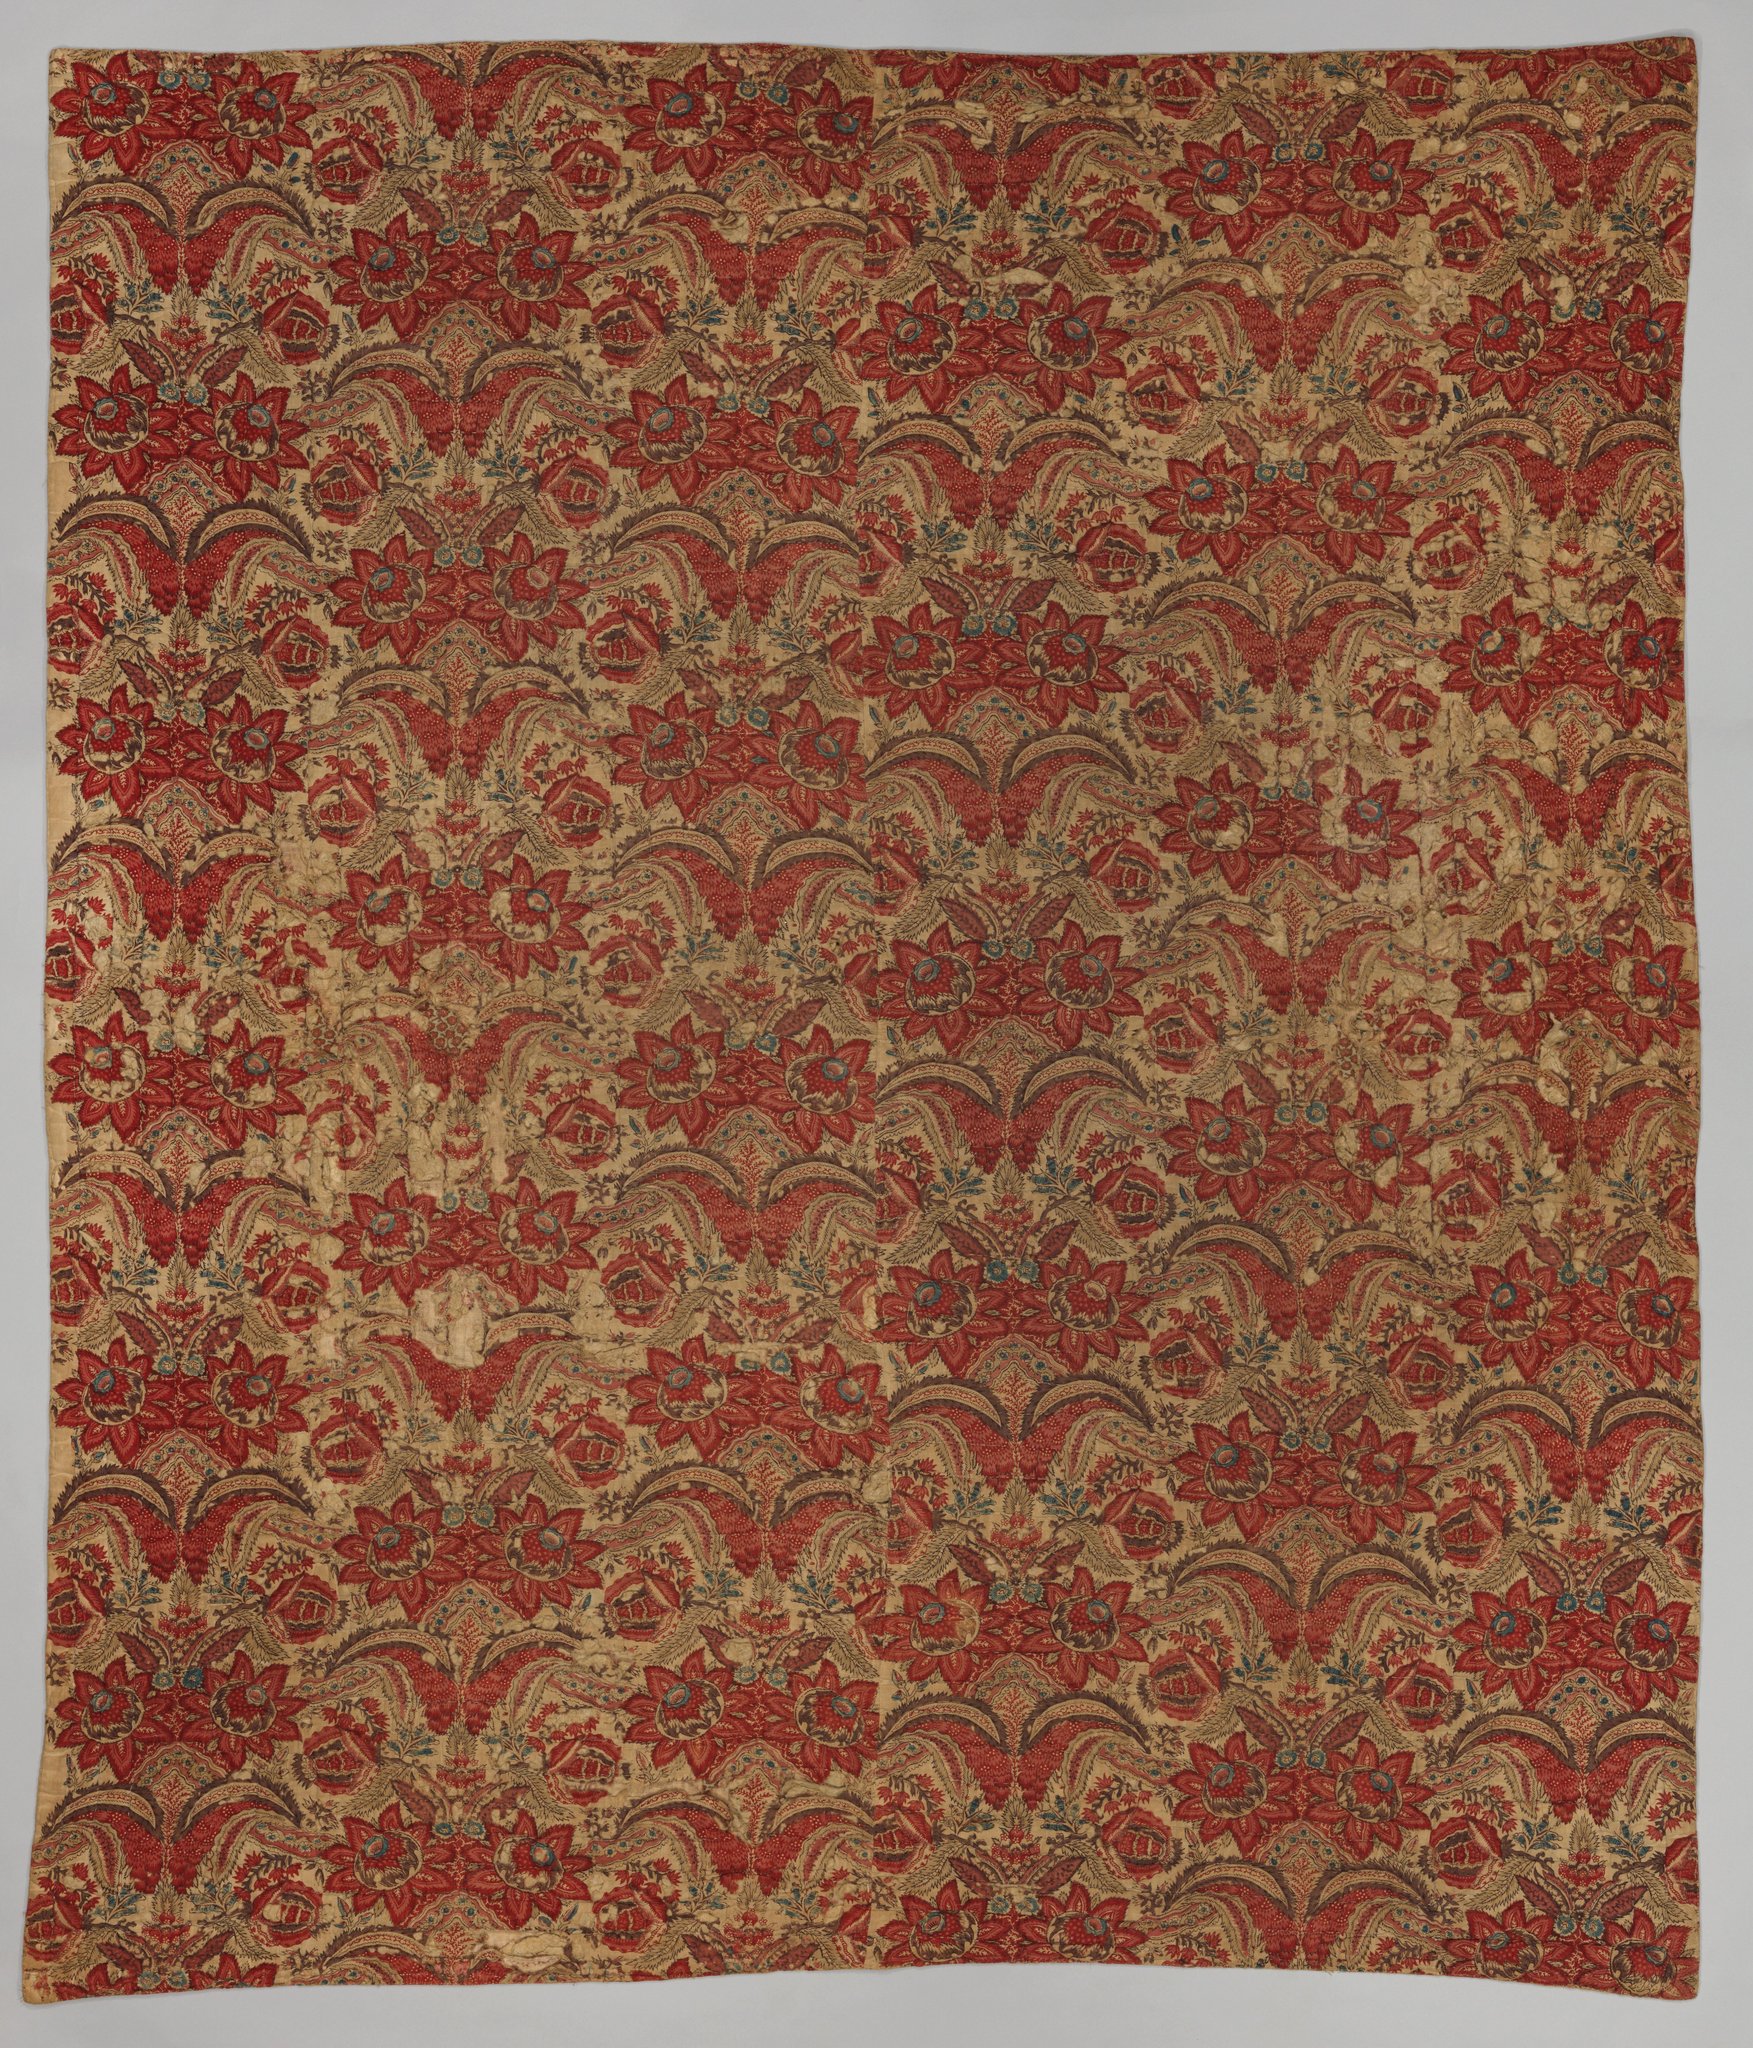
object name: bedspread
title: Sitsen sprei met gekleurde bloemen en palmetten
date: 1675-1700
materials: textile, cotton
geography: iran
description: Sprei met rode, donkerpaars en gele palmetten en rode bloemen met blauwe harten op een witte, geelgetinte achtergrond. De sprei is gevoerd met gestikt katoen en bedrukt met kleine rode bloemen, zwart omlijnd op een witte achtergrond. Oosters textiel.